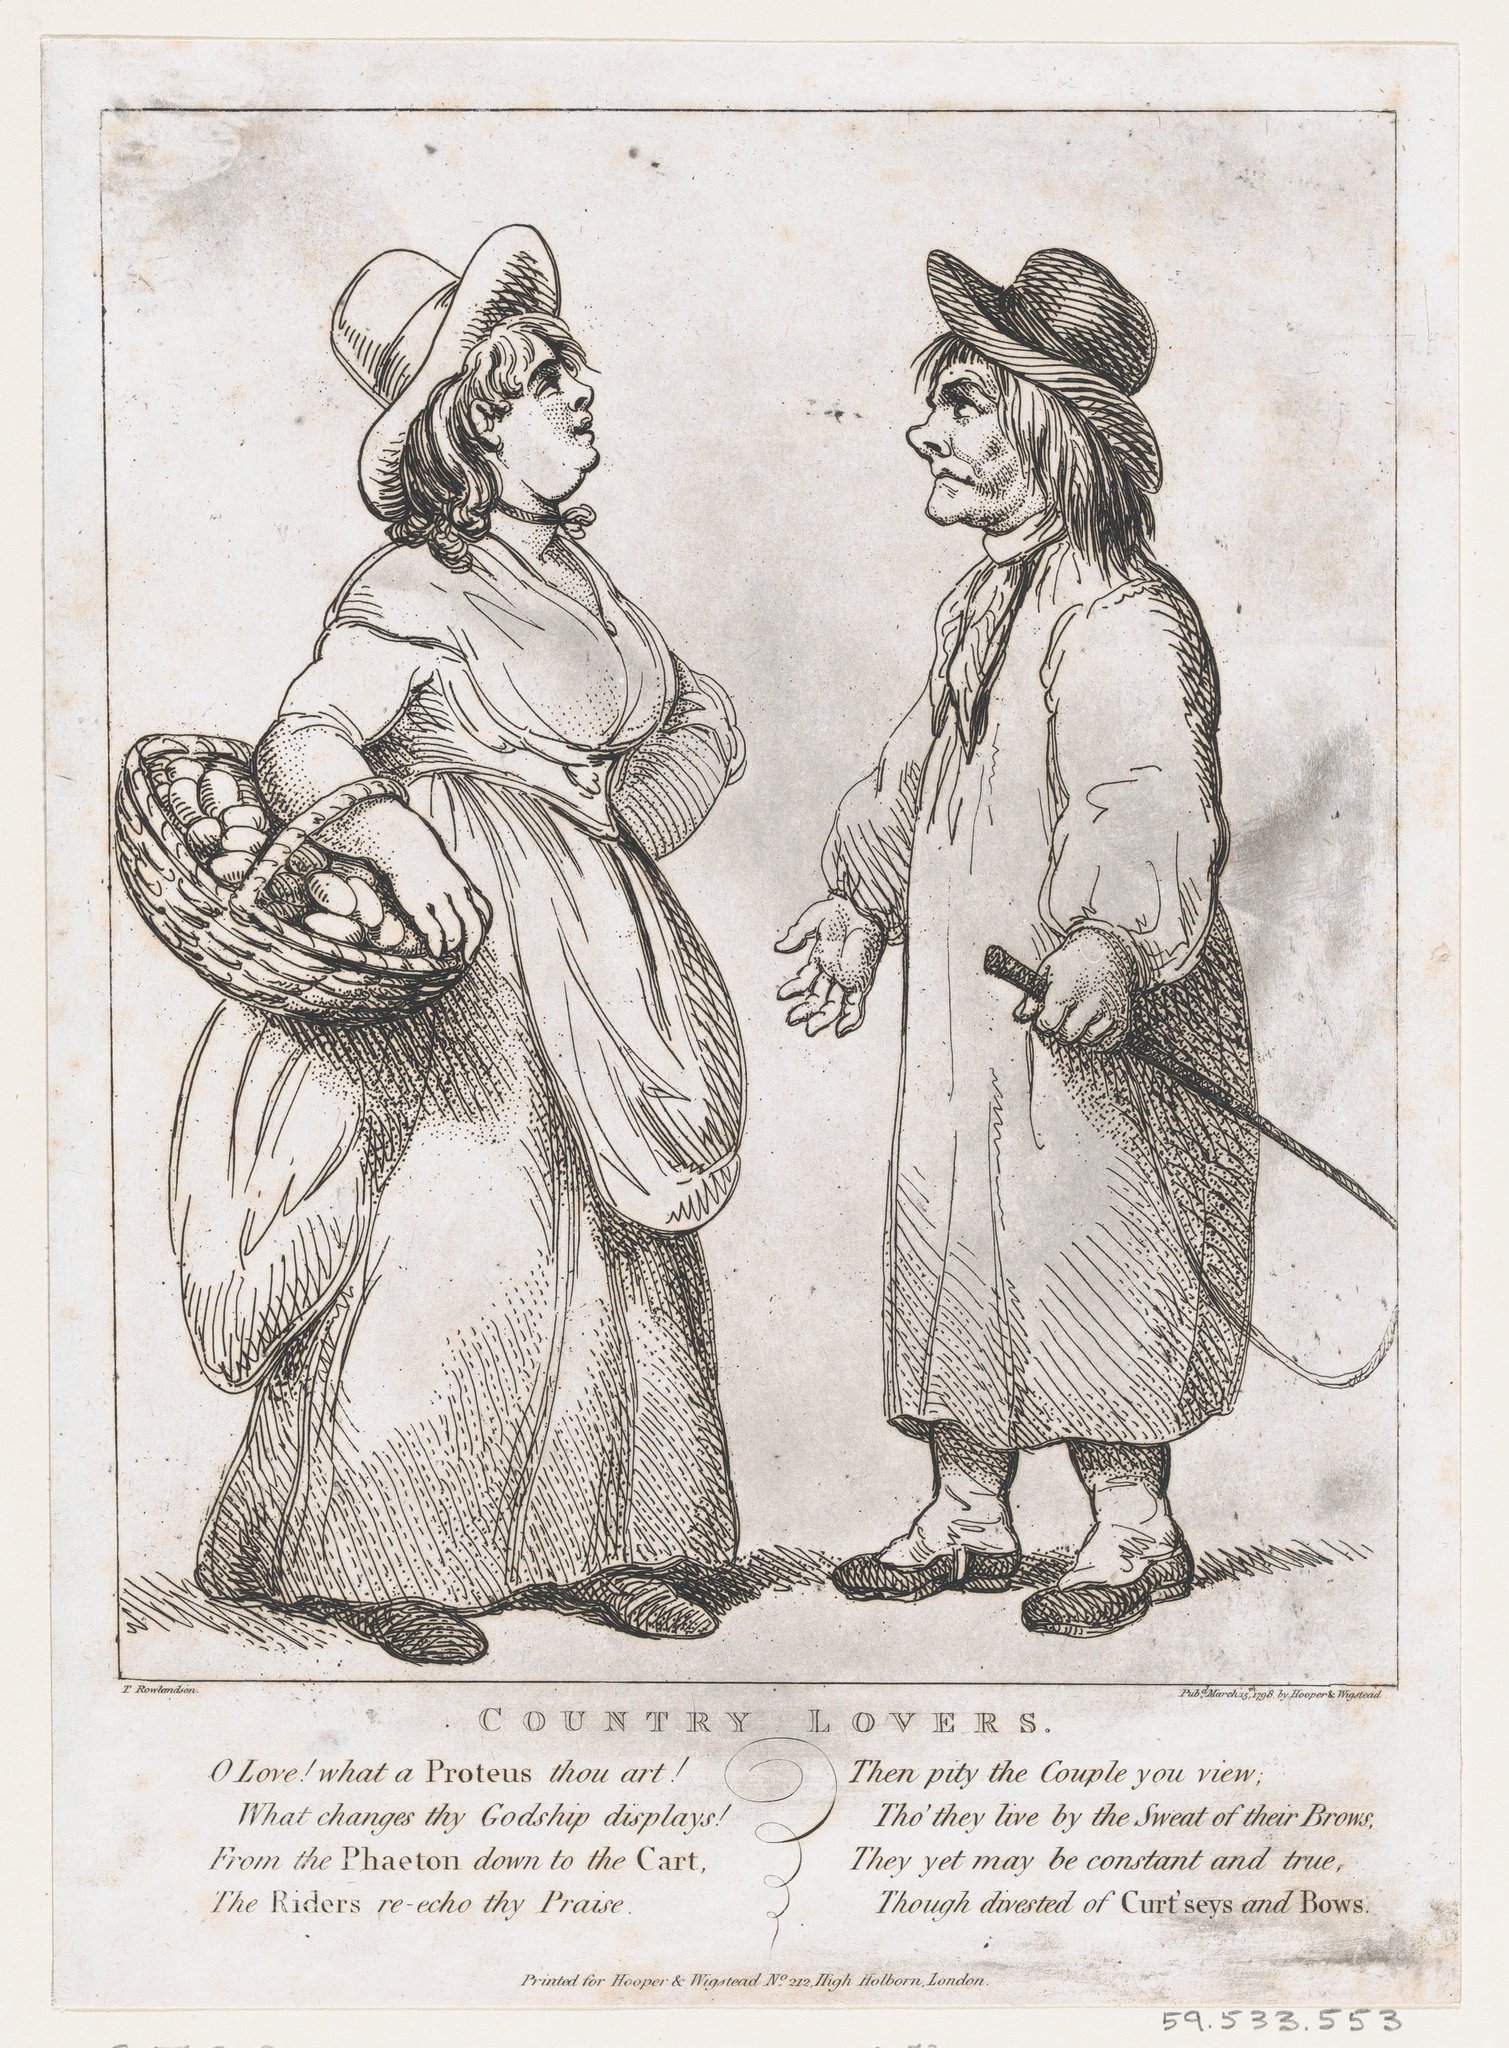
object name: print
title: Country Lovers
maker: thomas rowlandson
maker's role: artist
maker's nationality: british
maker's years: 1757-1827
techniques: etching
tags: men,lovers,women